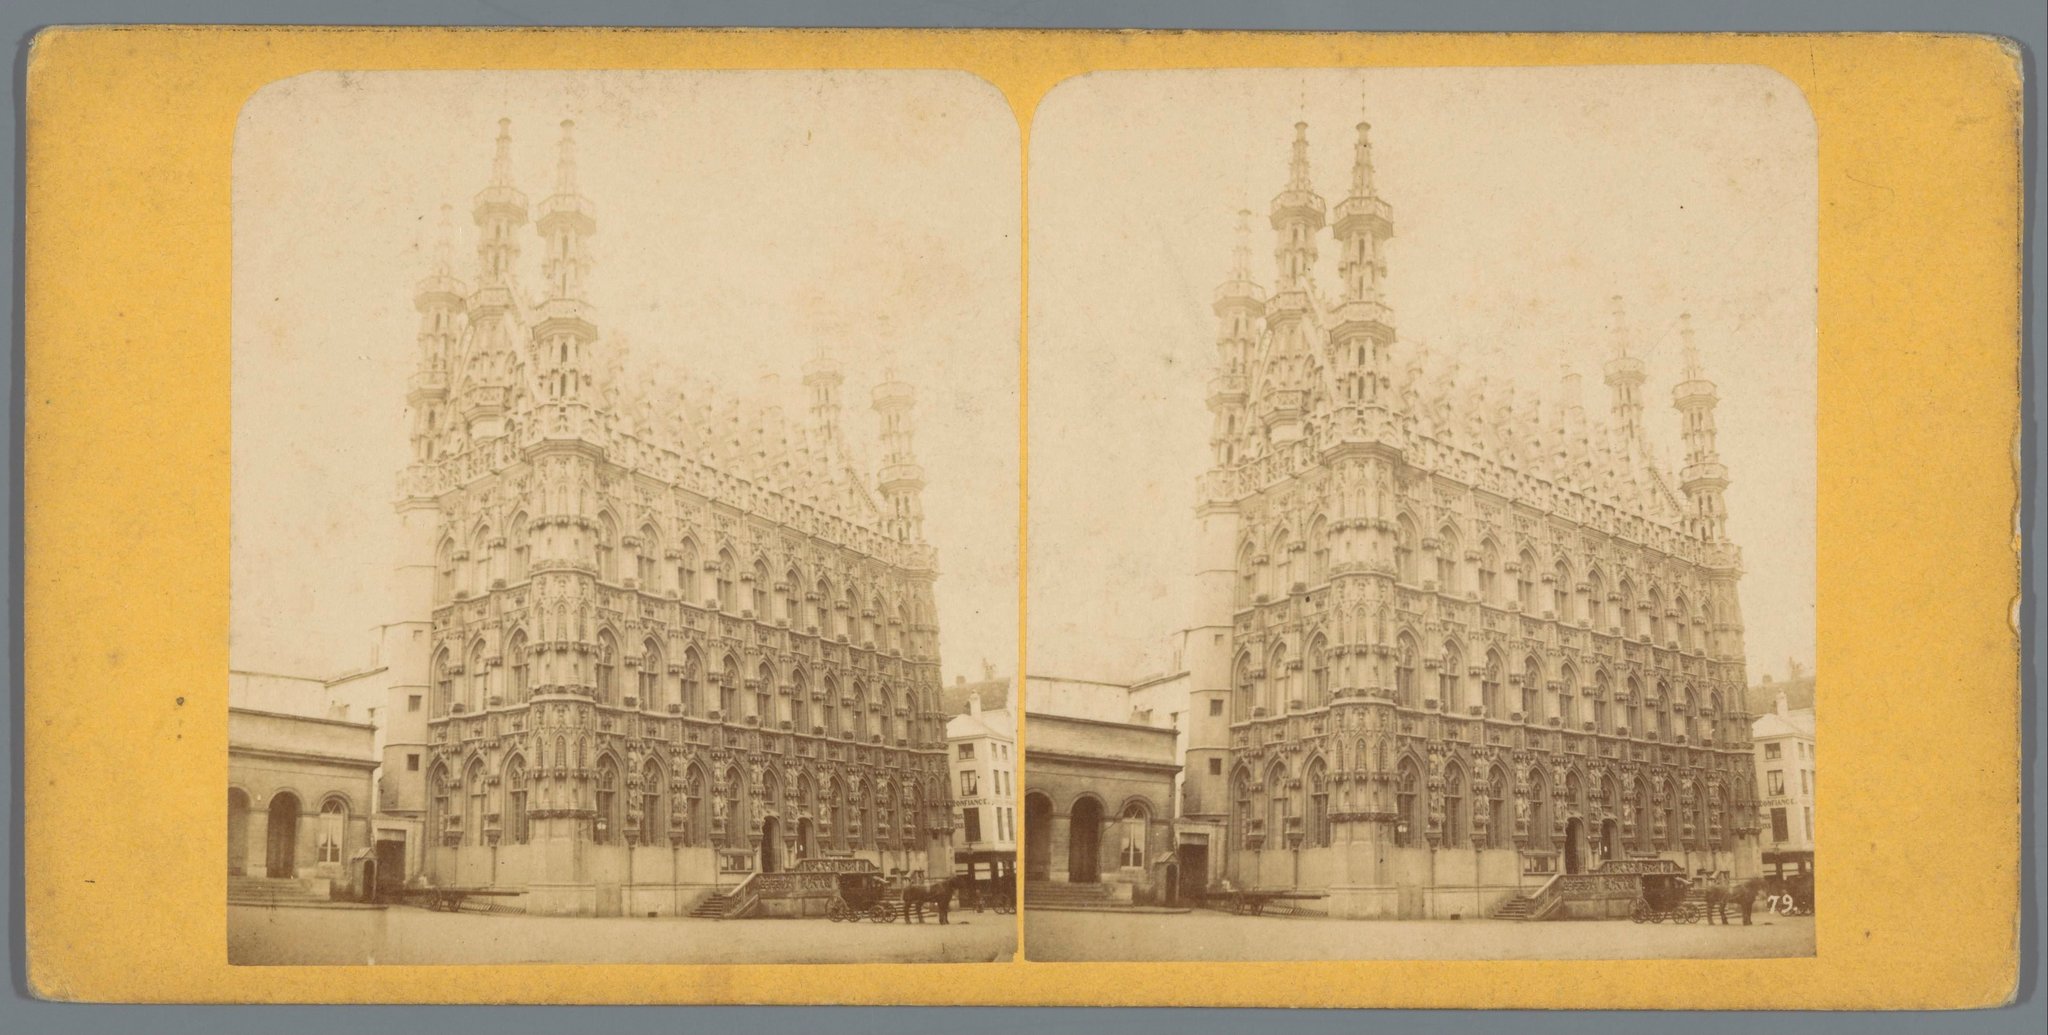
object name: stereograph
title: Hôtel-de-Ville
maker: bt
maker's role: fotograaf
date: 1861-1870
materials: cardboard, paper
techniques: albumen print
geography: leuven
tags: townhall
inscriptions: number: ‘No 79’, number: ‘79.’, inscription: ‘Province de Brabant./ Pop. 100,000 hoch.’